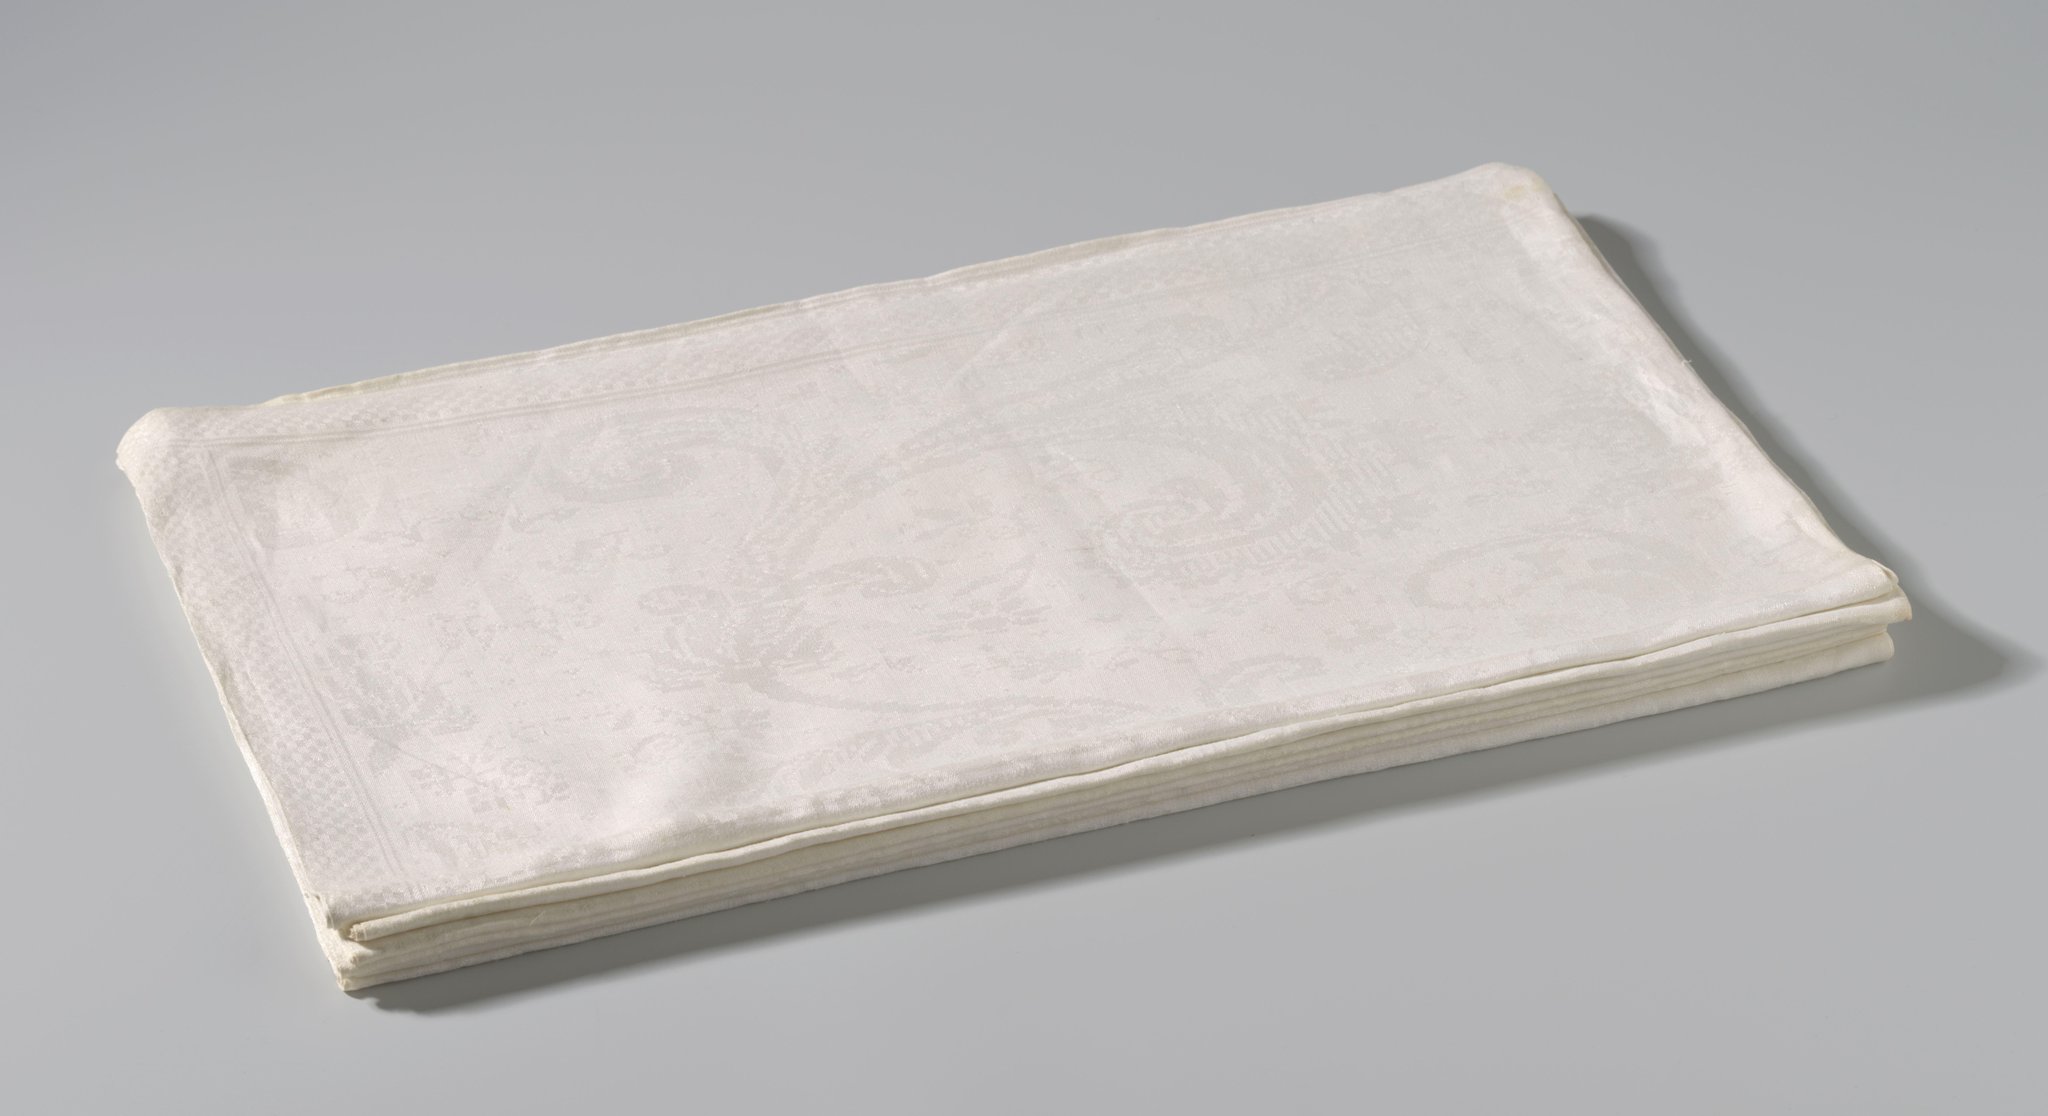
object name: tablecloth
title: Tafellaken van linnendamast met een bloempatroon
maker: Anonymous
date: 1680-1700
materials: linen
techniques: damask, weave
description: Tafellaken van linnendamast met voluten en gestrooide bloemen. Het laken is gemerkt: WCvS en CvB 24. Bij het tafellaken horen acht servetten (BK-1973-162-A t/m BK-1973-162-H).